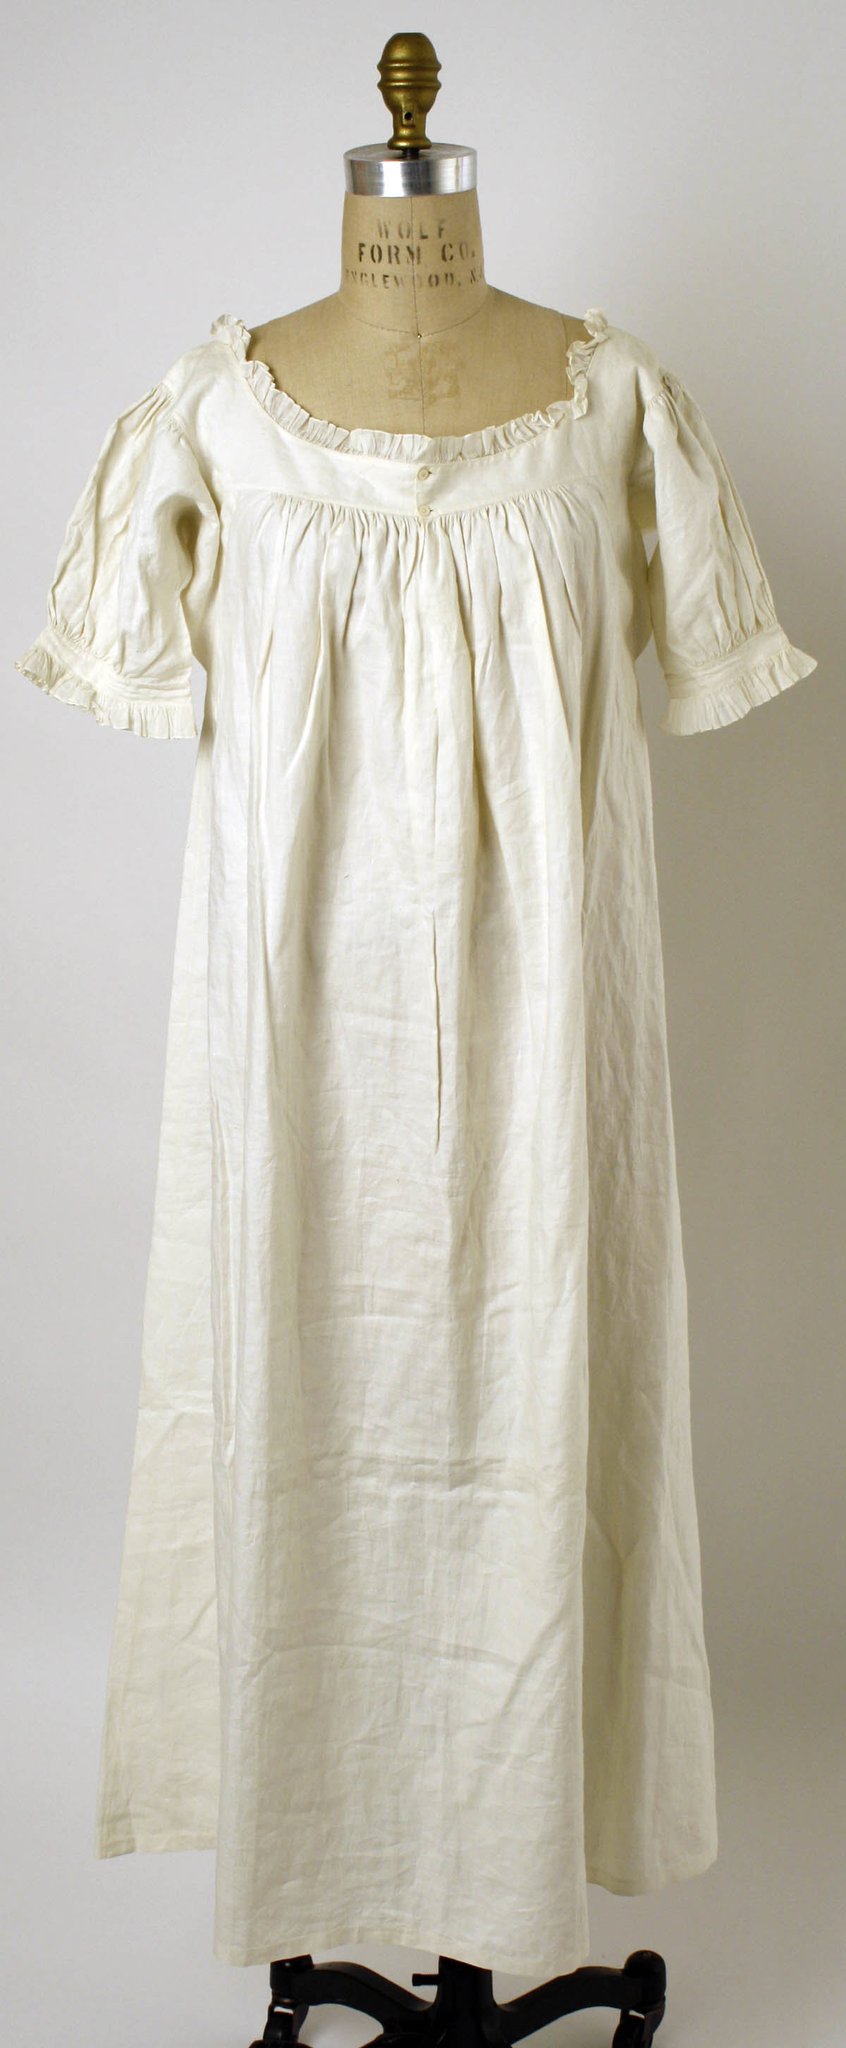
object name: nightgown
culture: american or european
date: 1830-1839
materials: linen